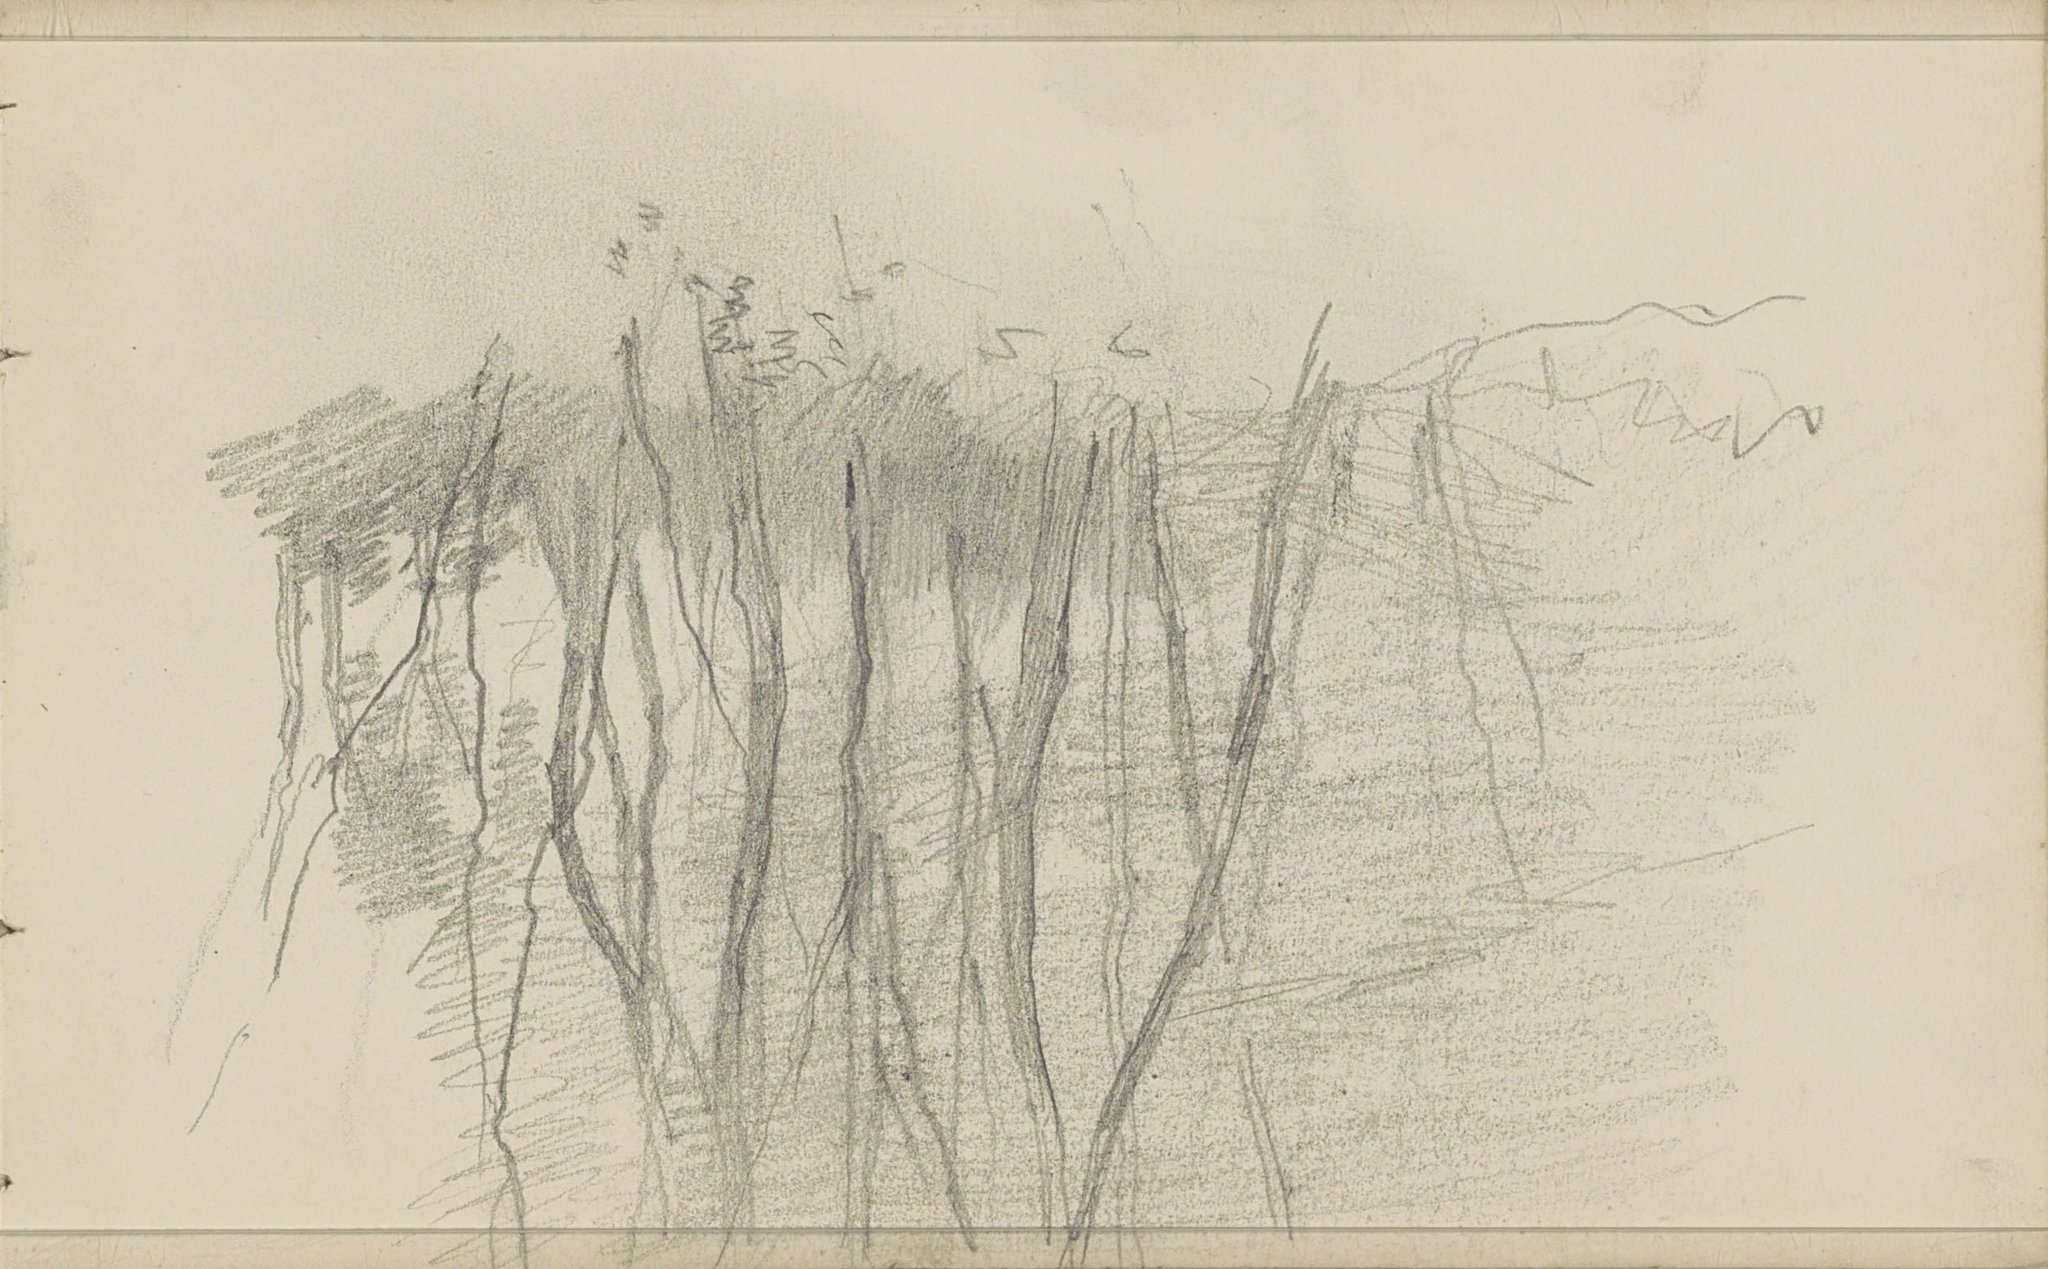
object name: sketchbook leaf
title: Bomen met kale takken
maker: anton mauve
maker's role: draughtsman, painter, print maker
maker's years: 1838-1888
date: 1848-1888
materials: paper, pencil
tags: trees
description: Blad 25 recto uit een schetsboek met 42 bladen.